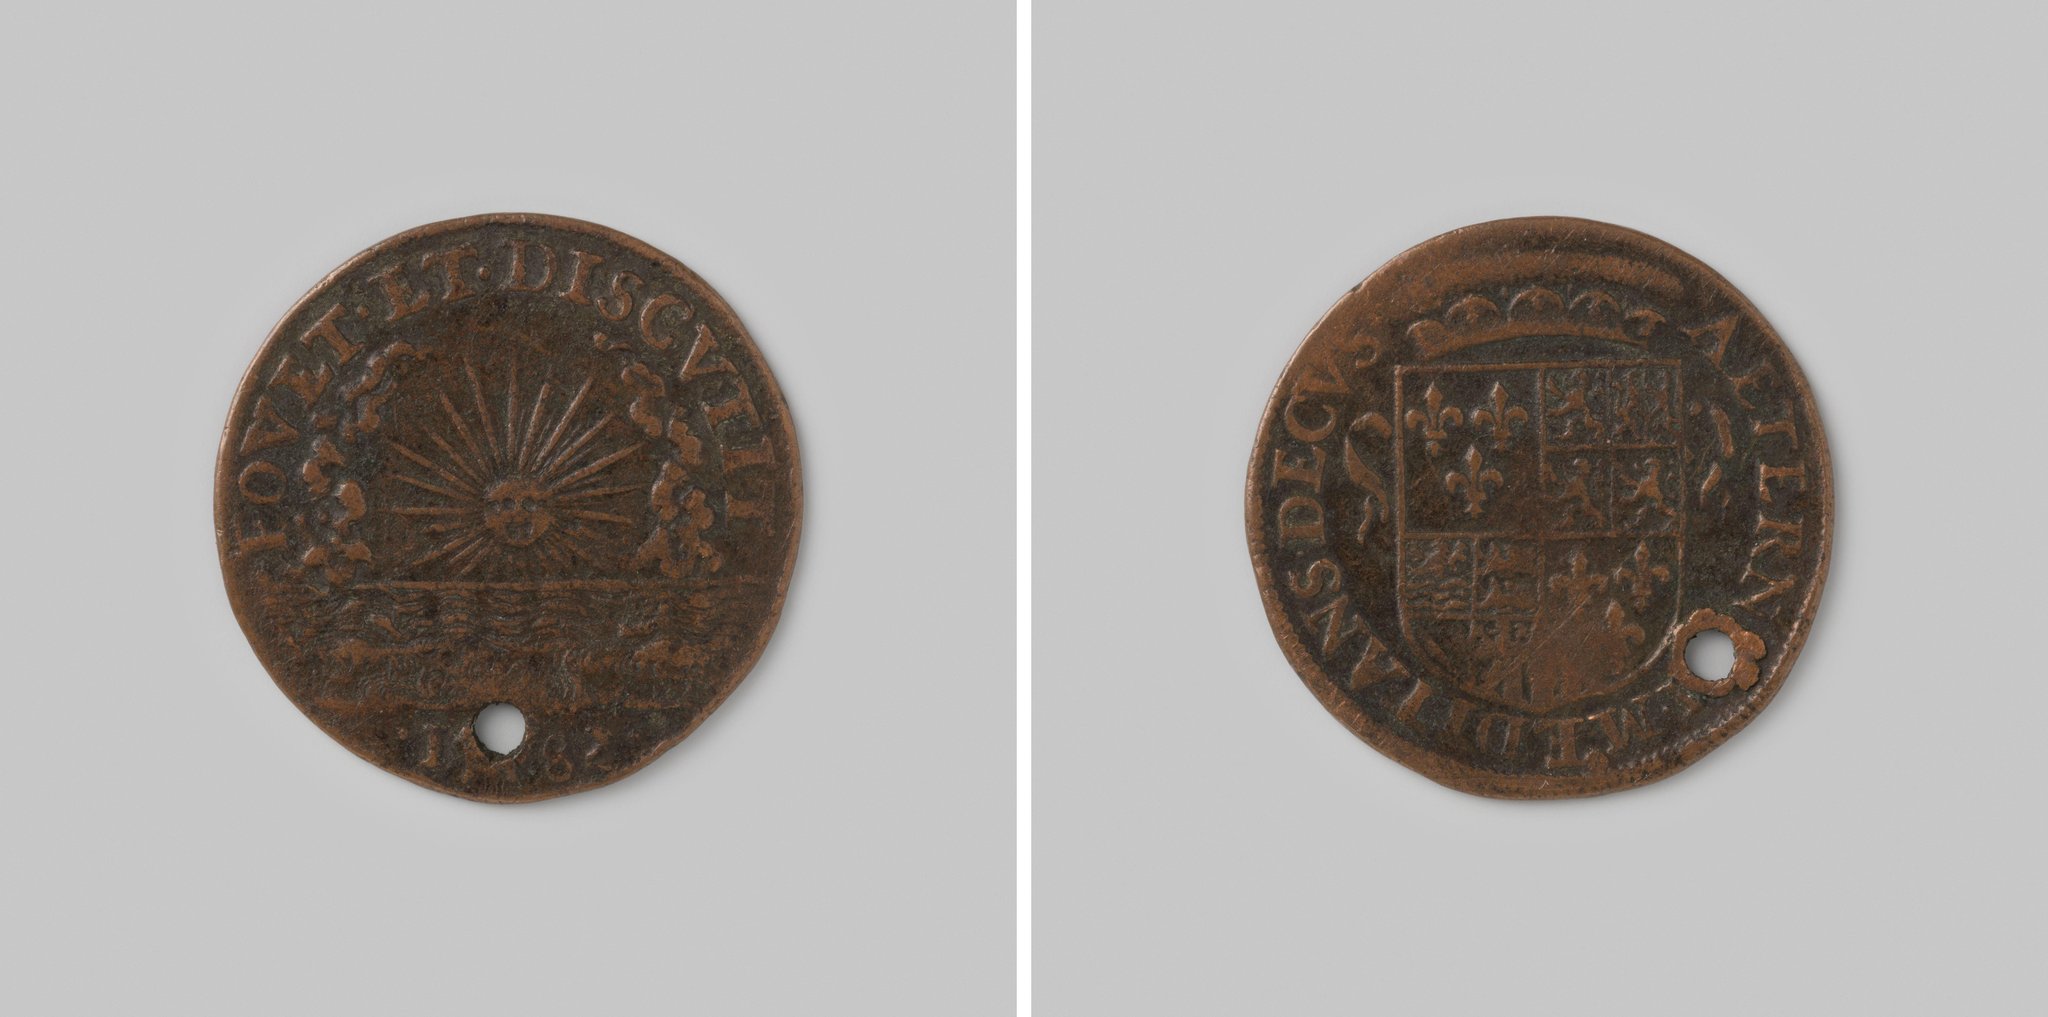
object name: jeton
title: Rekenpenning op de inhuldiging van de Hertog van Anjou in Vlaanderen 1582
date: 1582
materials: copper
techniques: striking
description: Koperen penning met doorboring, op de voorzijde de zon die boven zee door de wolken breekt, met omschrift en afsnedetekst, op de keerzijde een gekroond wapenschild met omschrift.